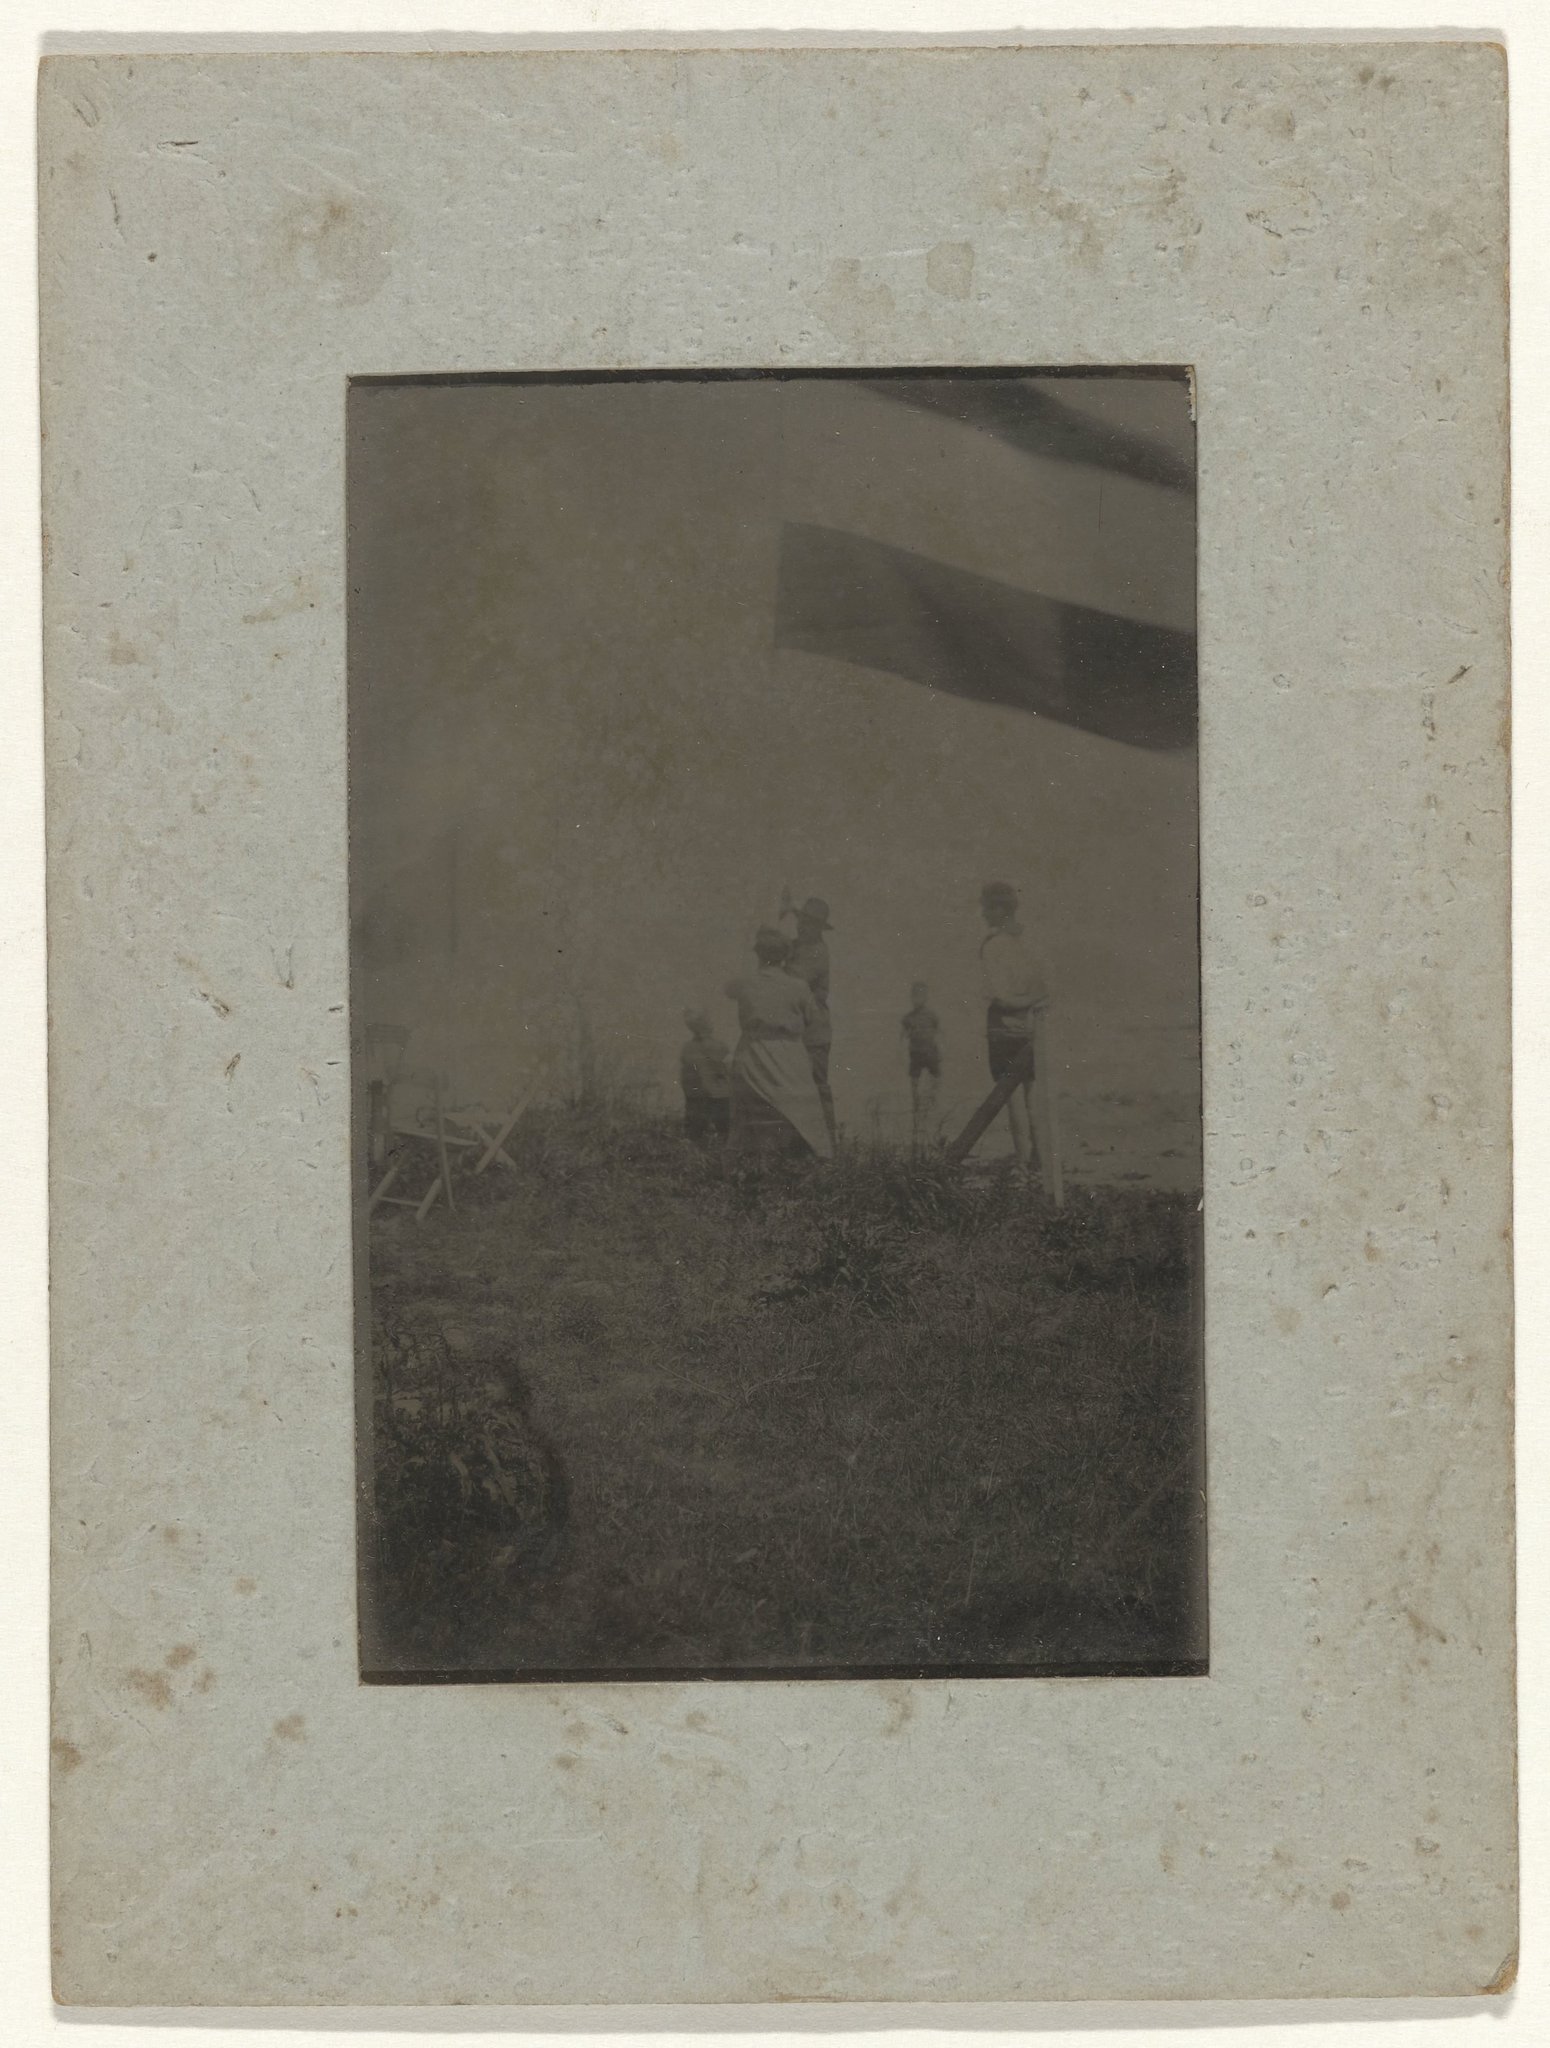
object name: photograph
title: Hijsen van de Nederlandse vlag aan het strand van Valkeveen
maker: Anonymous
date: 1915-1925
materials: cardboard, iron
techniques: ferrotyping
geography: valkeveen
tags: beach (as place of recreation), flag raising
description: Het hijsen van de Nederlandse vlag aan het strand van Valkeveen.